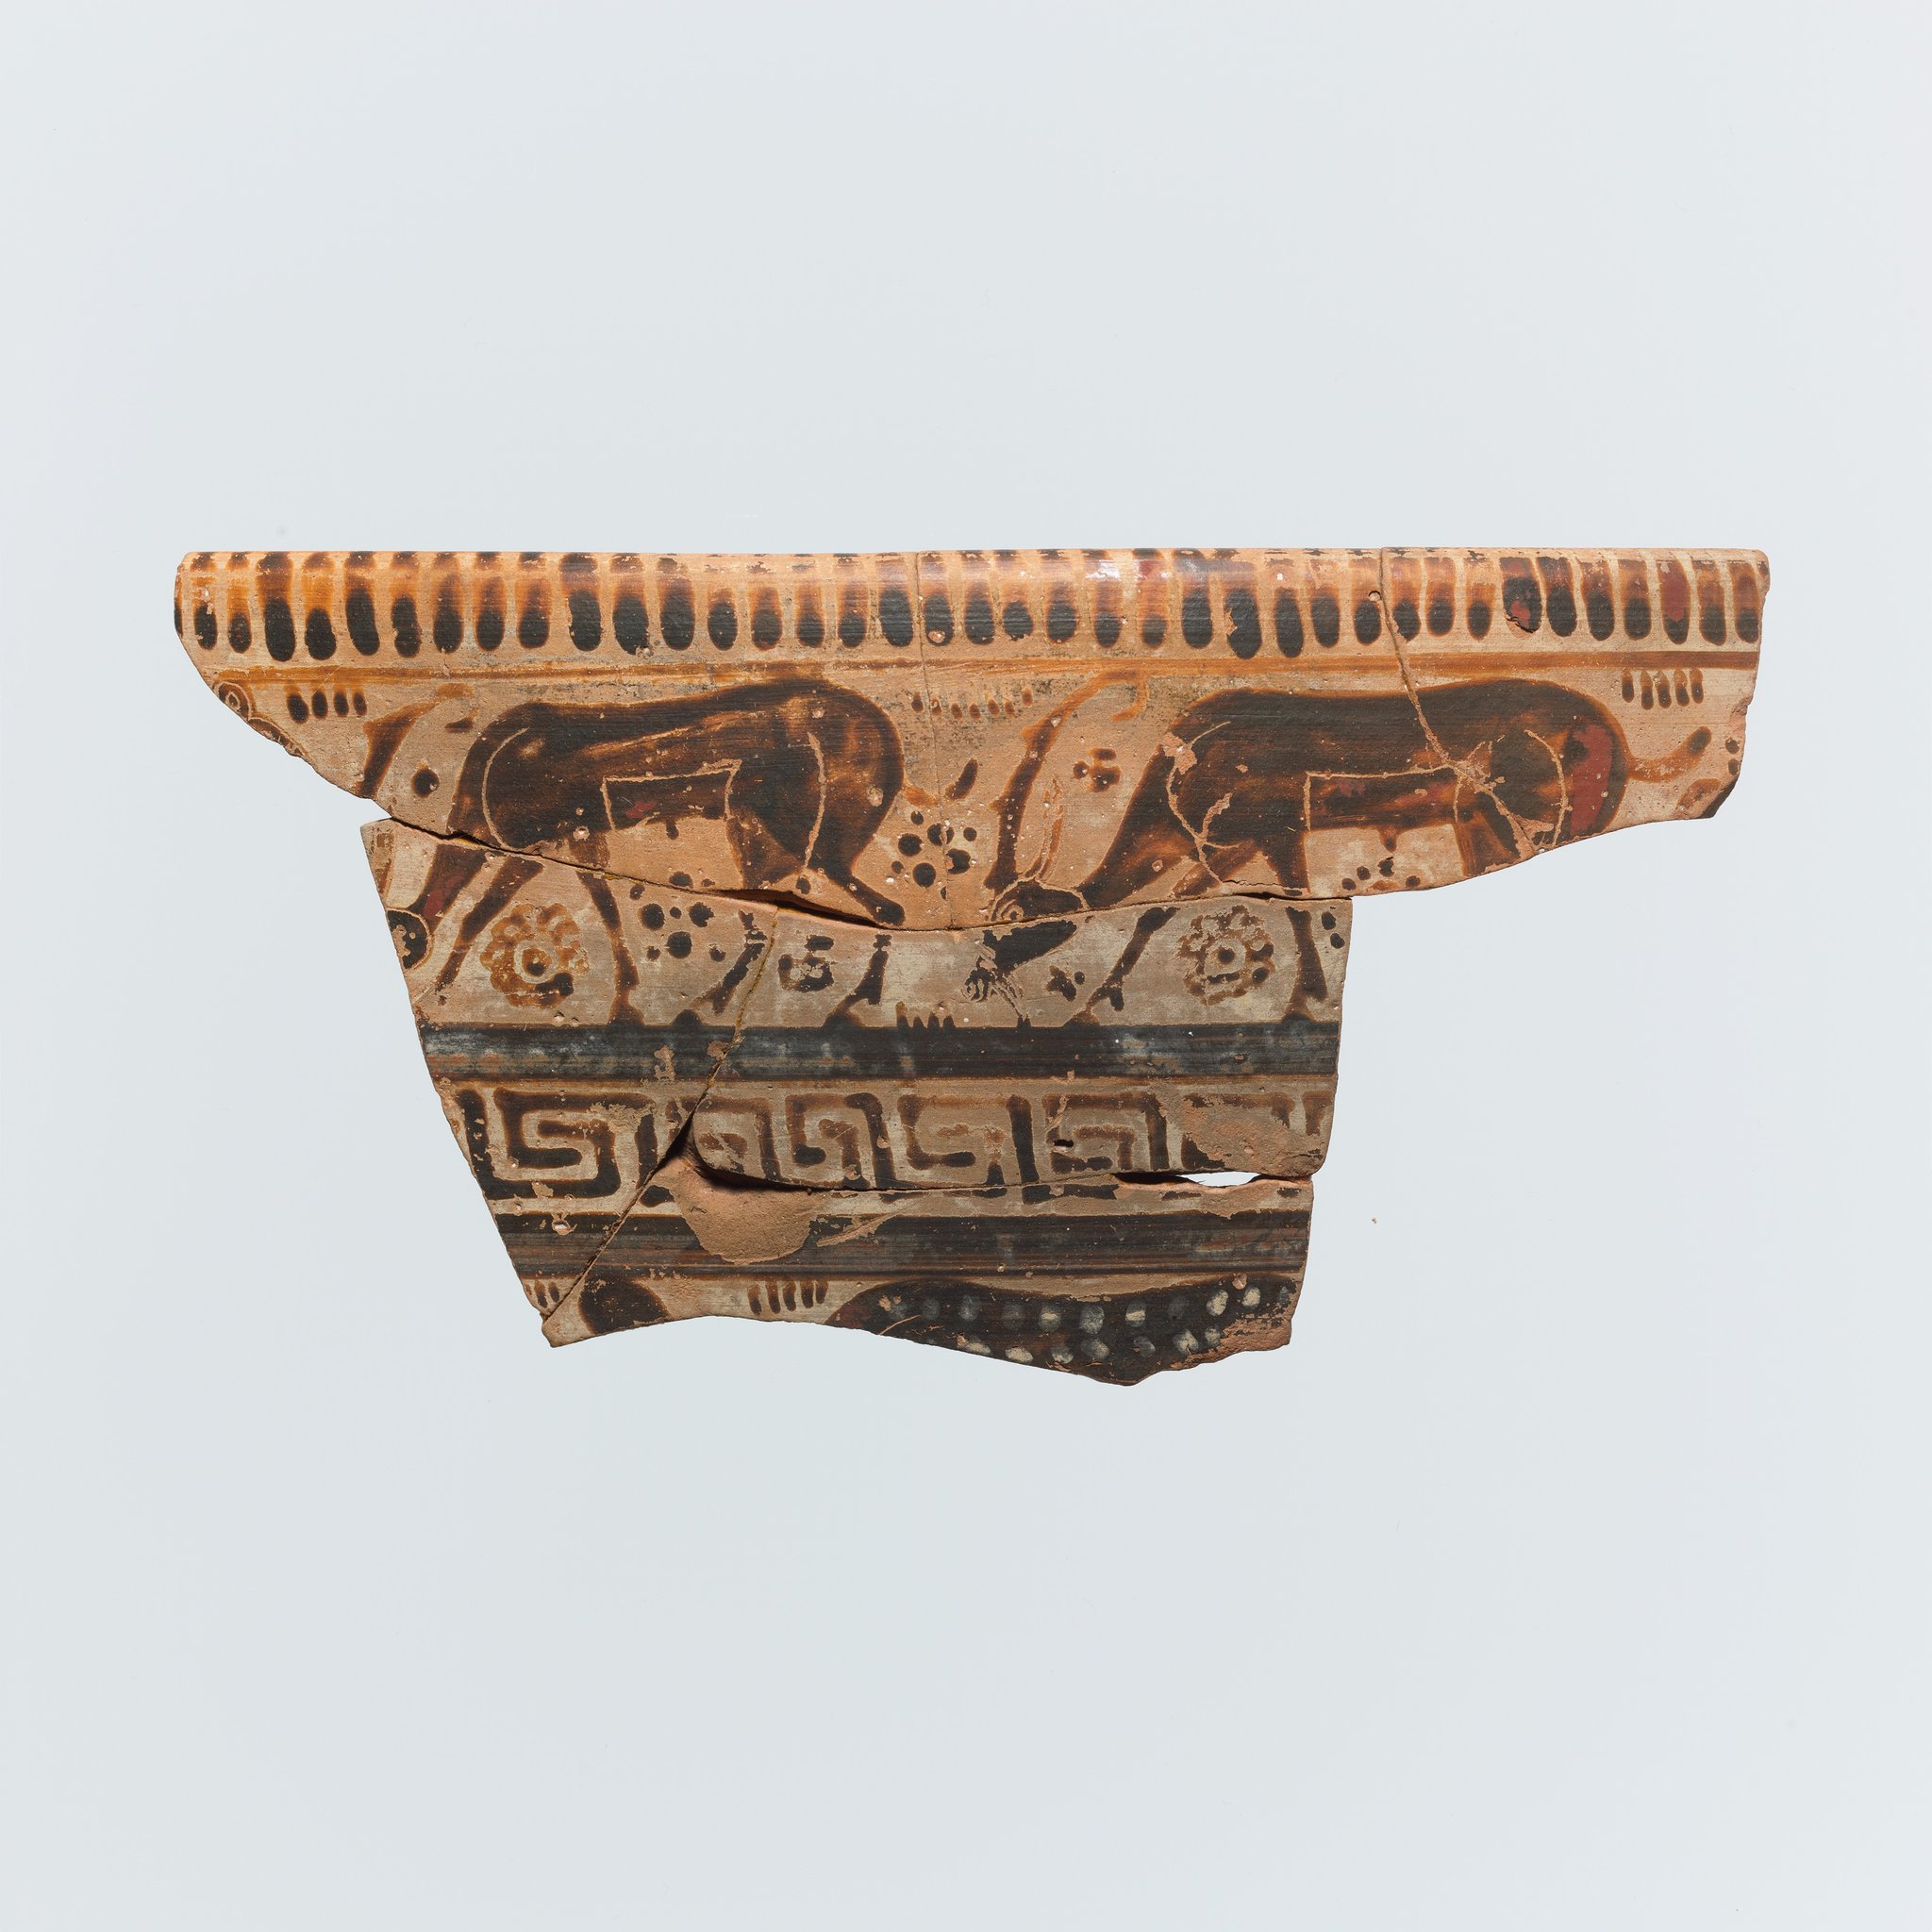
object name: krater fragment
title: Fragment of a terracotta krater (mixing bowl)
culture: east greek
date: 600-501 BCE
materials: terracotta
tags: deer,goats